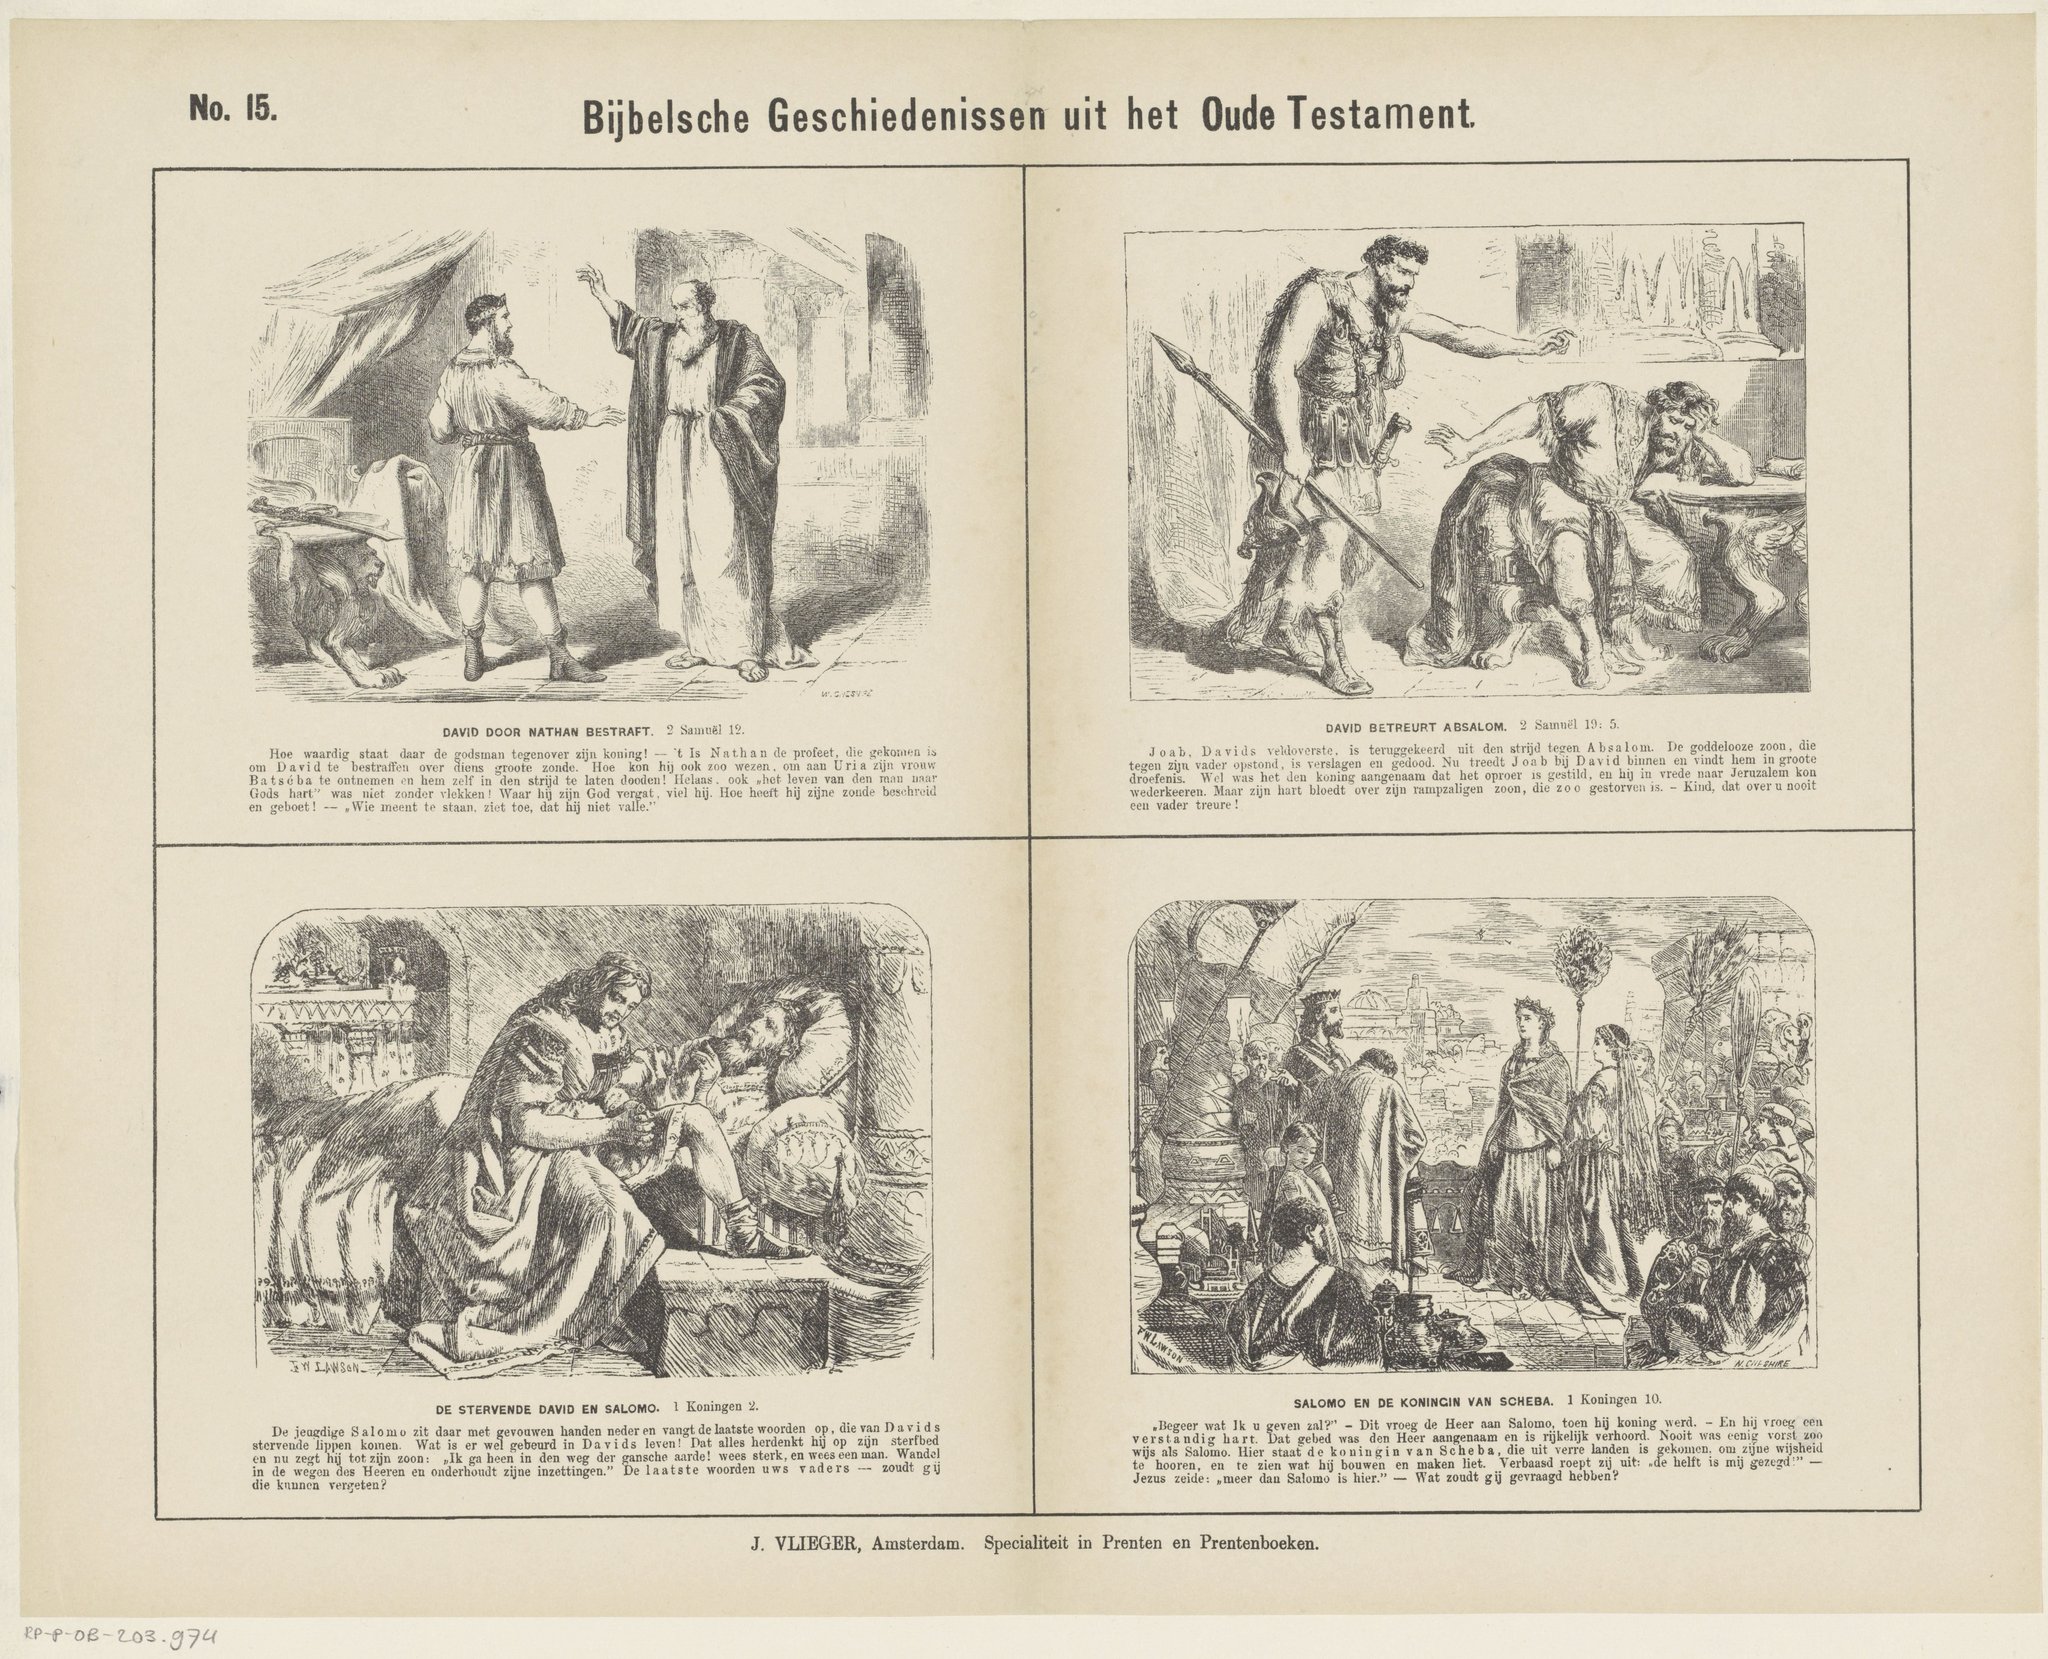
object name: print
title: Bijbelsche geschiedenissen uit het Oude Testament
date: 1871-1908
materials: paper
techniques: letterpress printing, engraving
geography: amsterdam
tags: david's instructions to solomon, david mourning for absalom's death, david rebuked by nathan, solomon and the queen of sheba (1 kings 10:1-3; 2 chronicles 9:1-9), old testament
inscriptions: collector's mark: Lugt 2760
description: Blad met 4 voorstellingen van verhalen uit het Oude Testament. David wordt door Natan bestraft, David treurt om de dood van zijn zoon Absalom, de stervende David liggend in bed met zijn zoon Salomo aan zijn zijde en Salomo en de koningin van Seba. Onder elke afbeelding de bijbehorende Bijbeltekst. Genummerd linksboven: No. 15.